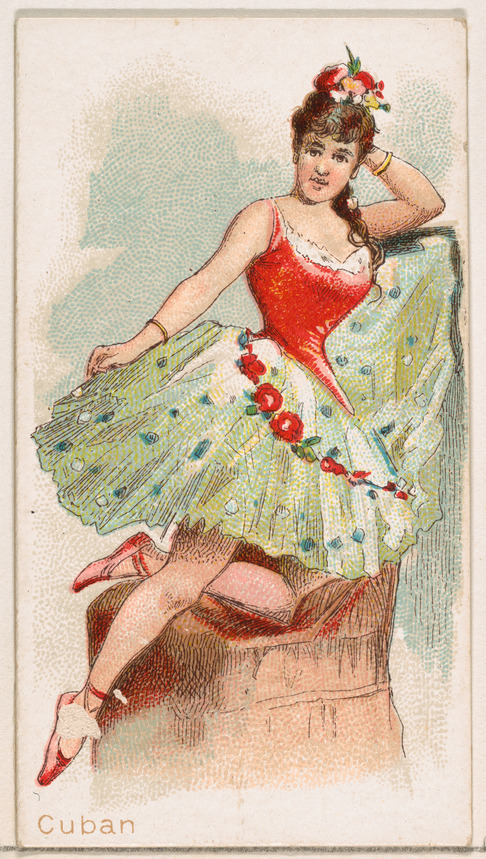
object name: print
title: Cuban Dancer, from the Dancing Women series (N186) issued by Wm. S. Kimball & Co.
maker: william s. kimball & company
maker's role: publisher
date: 1889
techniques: color lithograph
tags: women,dancers